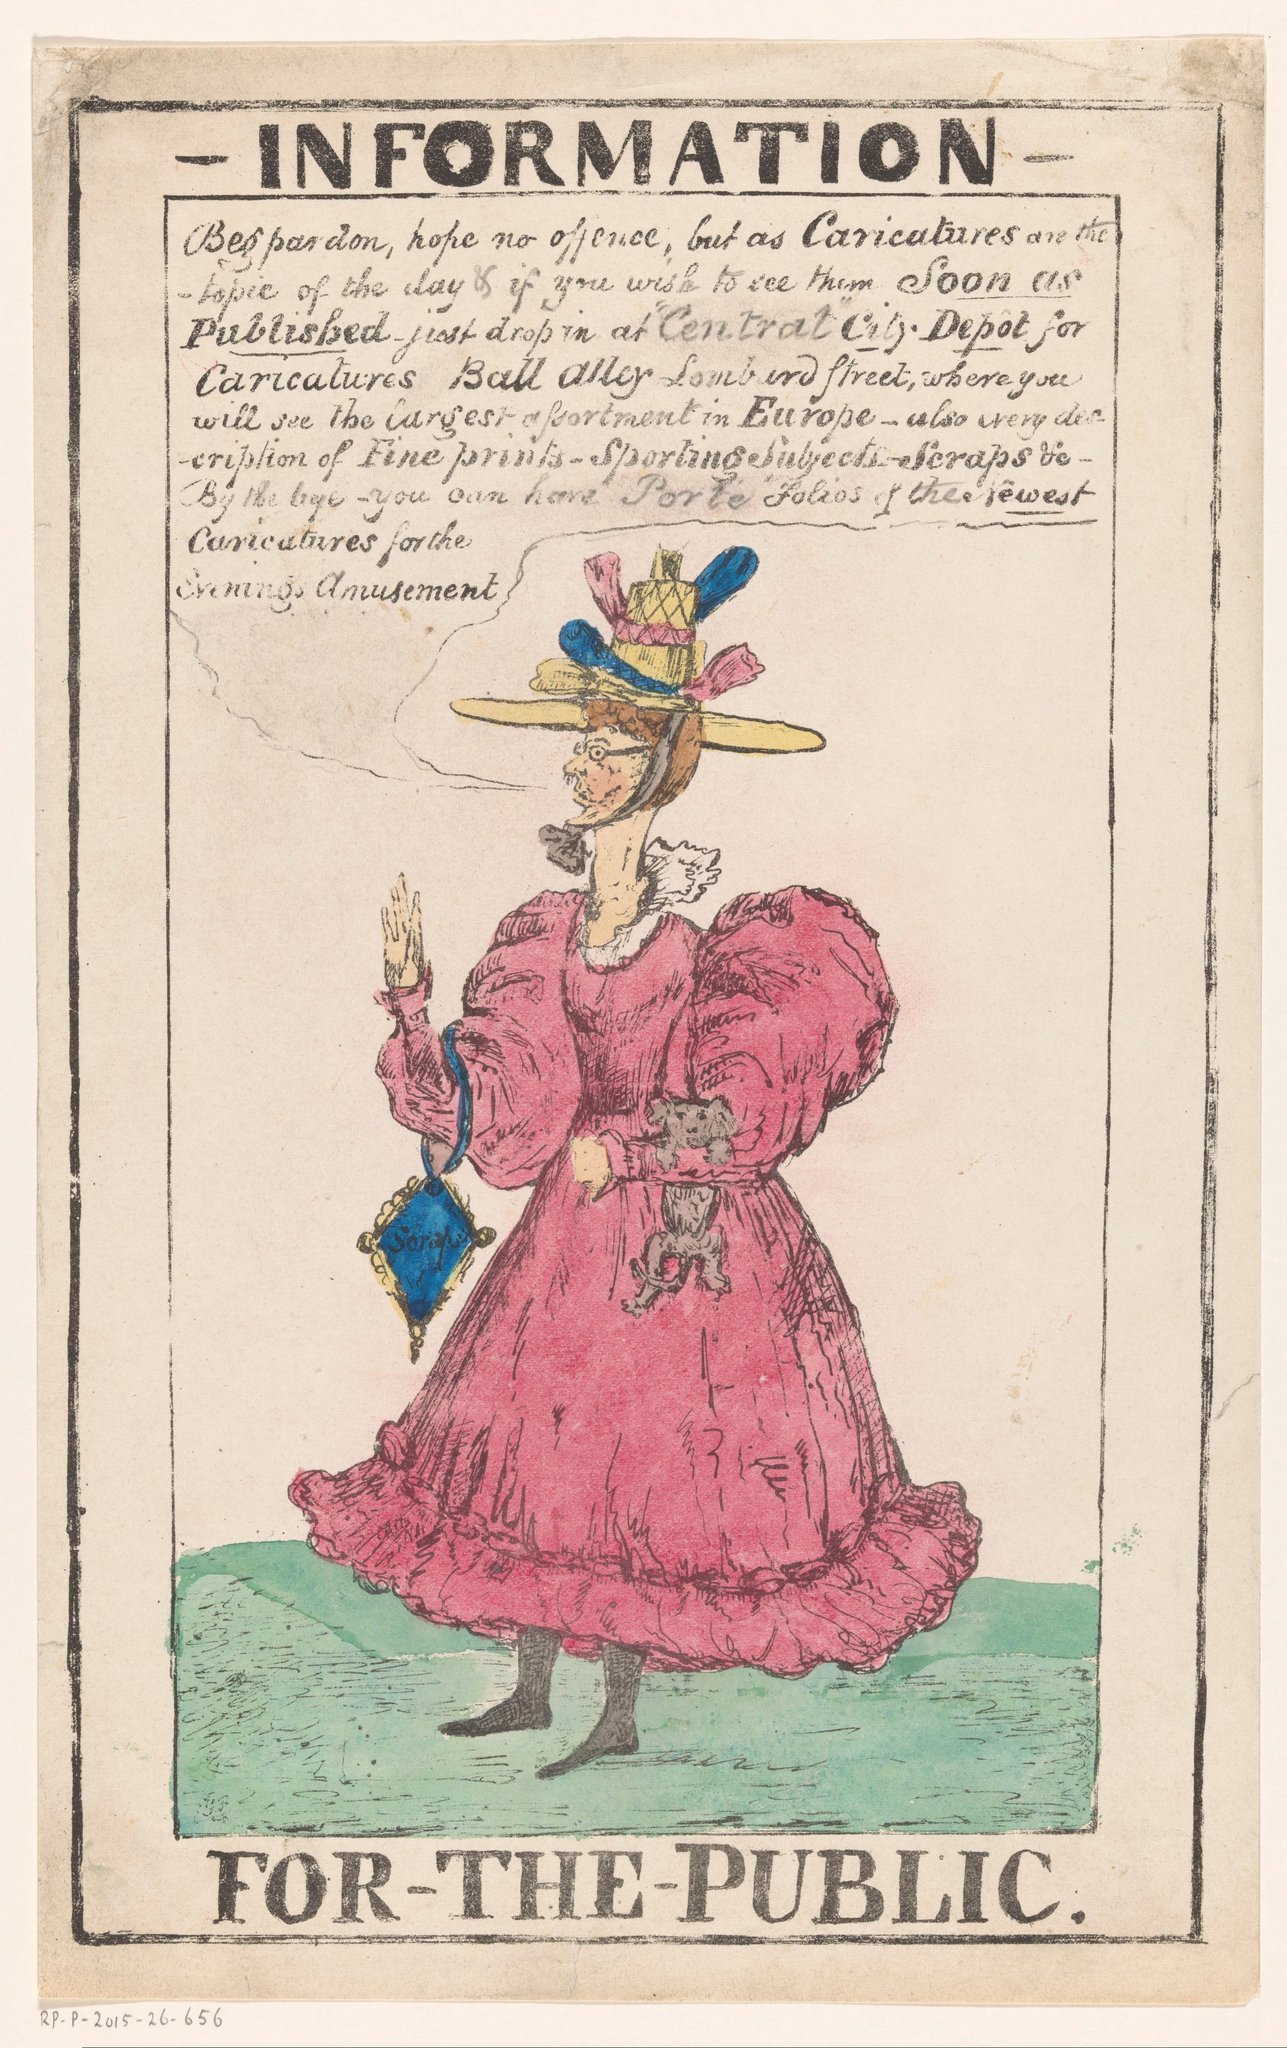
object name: print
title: Information for the public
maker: Anonymous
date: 1850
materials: paper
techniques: hand coloring, lithograph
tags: caricatures (human types)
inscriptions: collector's mark: Lugt 2228, collector's mark: Lugt 4779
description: Karikatuur van een vrouw, mogelijk een verklede man, in een roze jurk met een hoed op haar hoofd. Onder haar rechterarm een handtas en onder haar linkerarm een schoothondje.